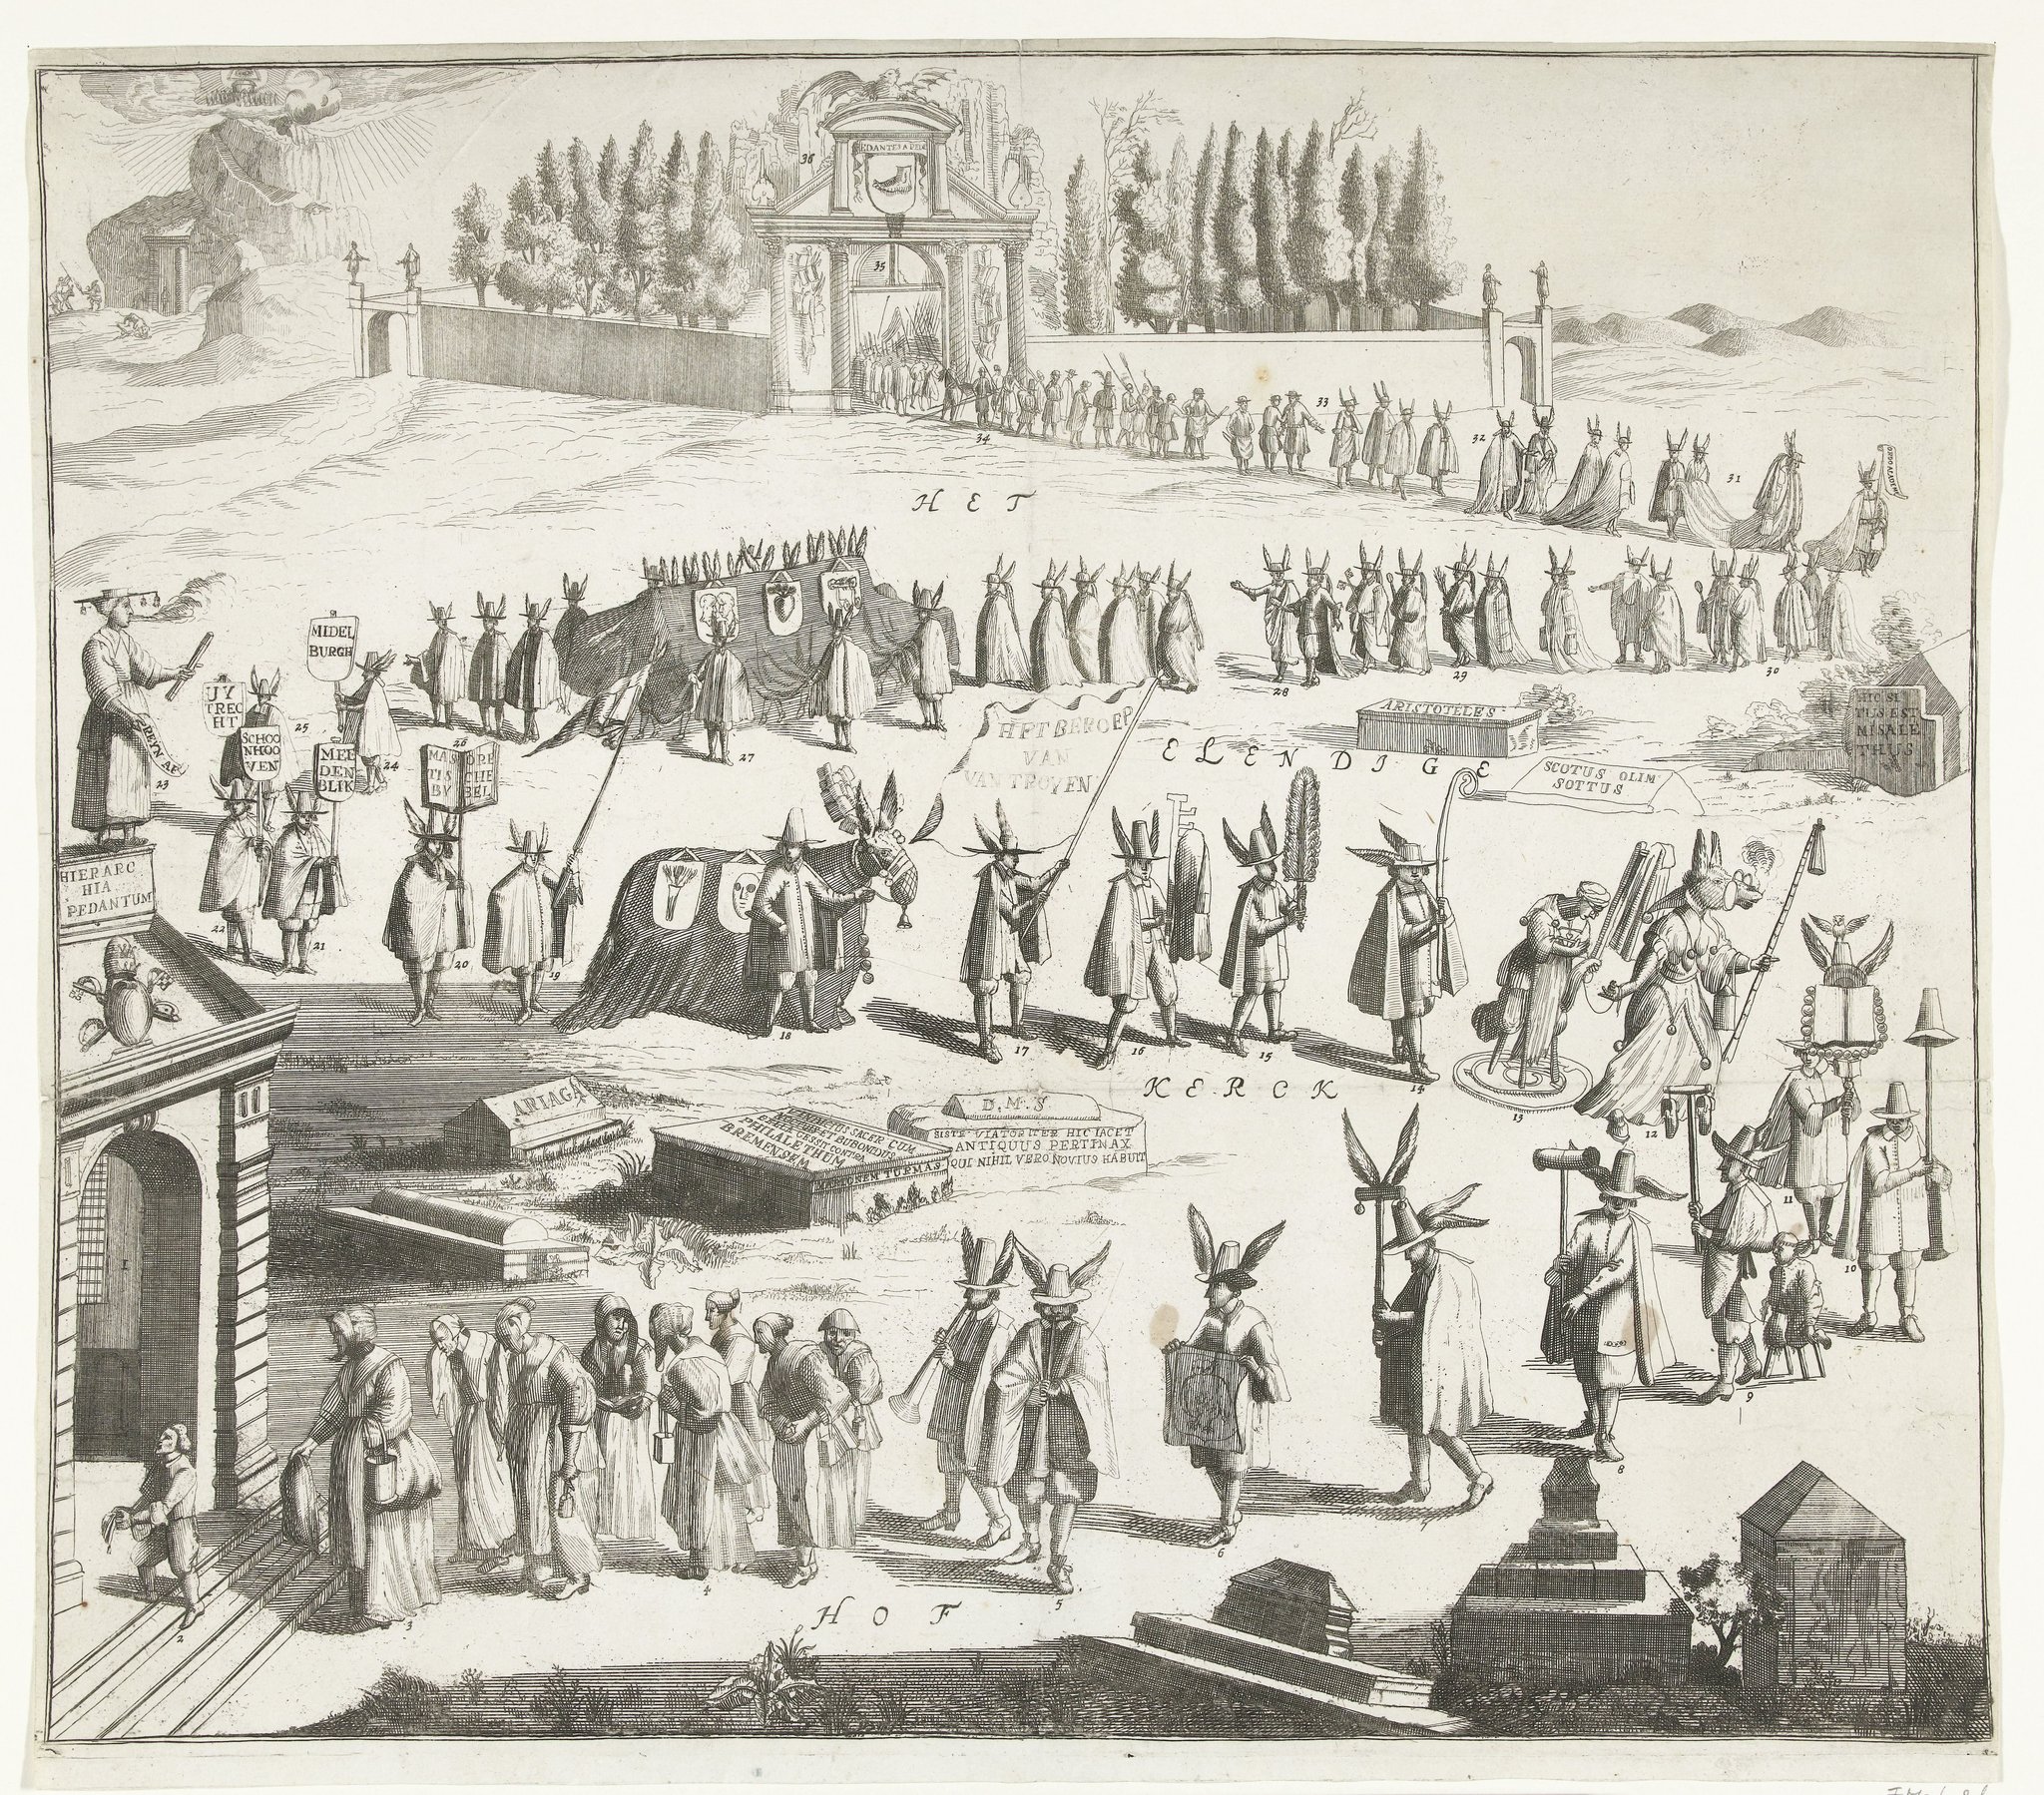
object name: cartoon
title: Spotprent van de begrafenis van dominee Abraham van de Velde, 1677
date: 1677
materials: paper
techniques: etching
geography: northern netherlands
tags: cortege, funeral procession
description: Spotprent van de begrafenis van dominee Abraham van de Velde, 14 juni 1677. Een lange begrafenisstoet van 4 rijen mannen met steiloren of ezelsoren trekt met het lijk van ds. van der Velde uit het Huis van Onrust over 'het elendige kerckhof', langs enige grafzerken met toepasselijke opschriften naar de kerk van de Geestelijke Oppermogendheid. Enige huilende zusters voeren de stoet aan; in het midden een vaandel met opschrift 'Het beroep van Troyen'. De voetiaanse dominee was eerder uit Utrecht verbannen en speelde in 1675 een rol in het conflict in Zeeland tussen de voetianen en coccejanen.